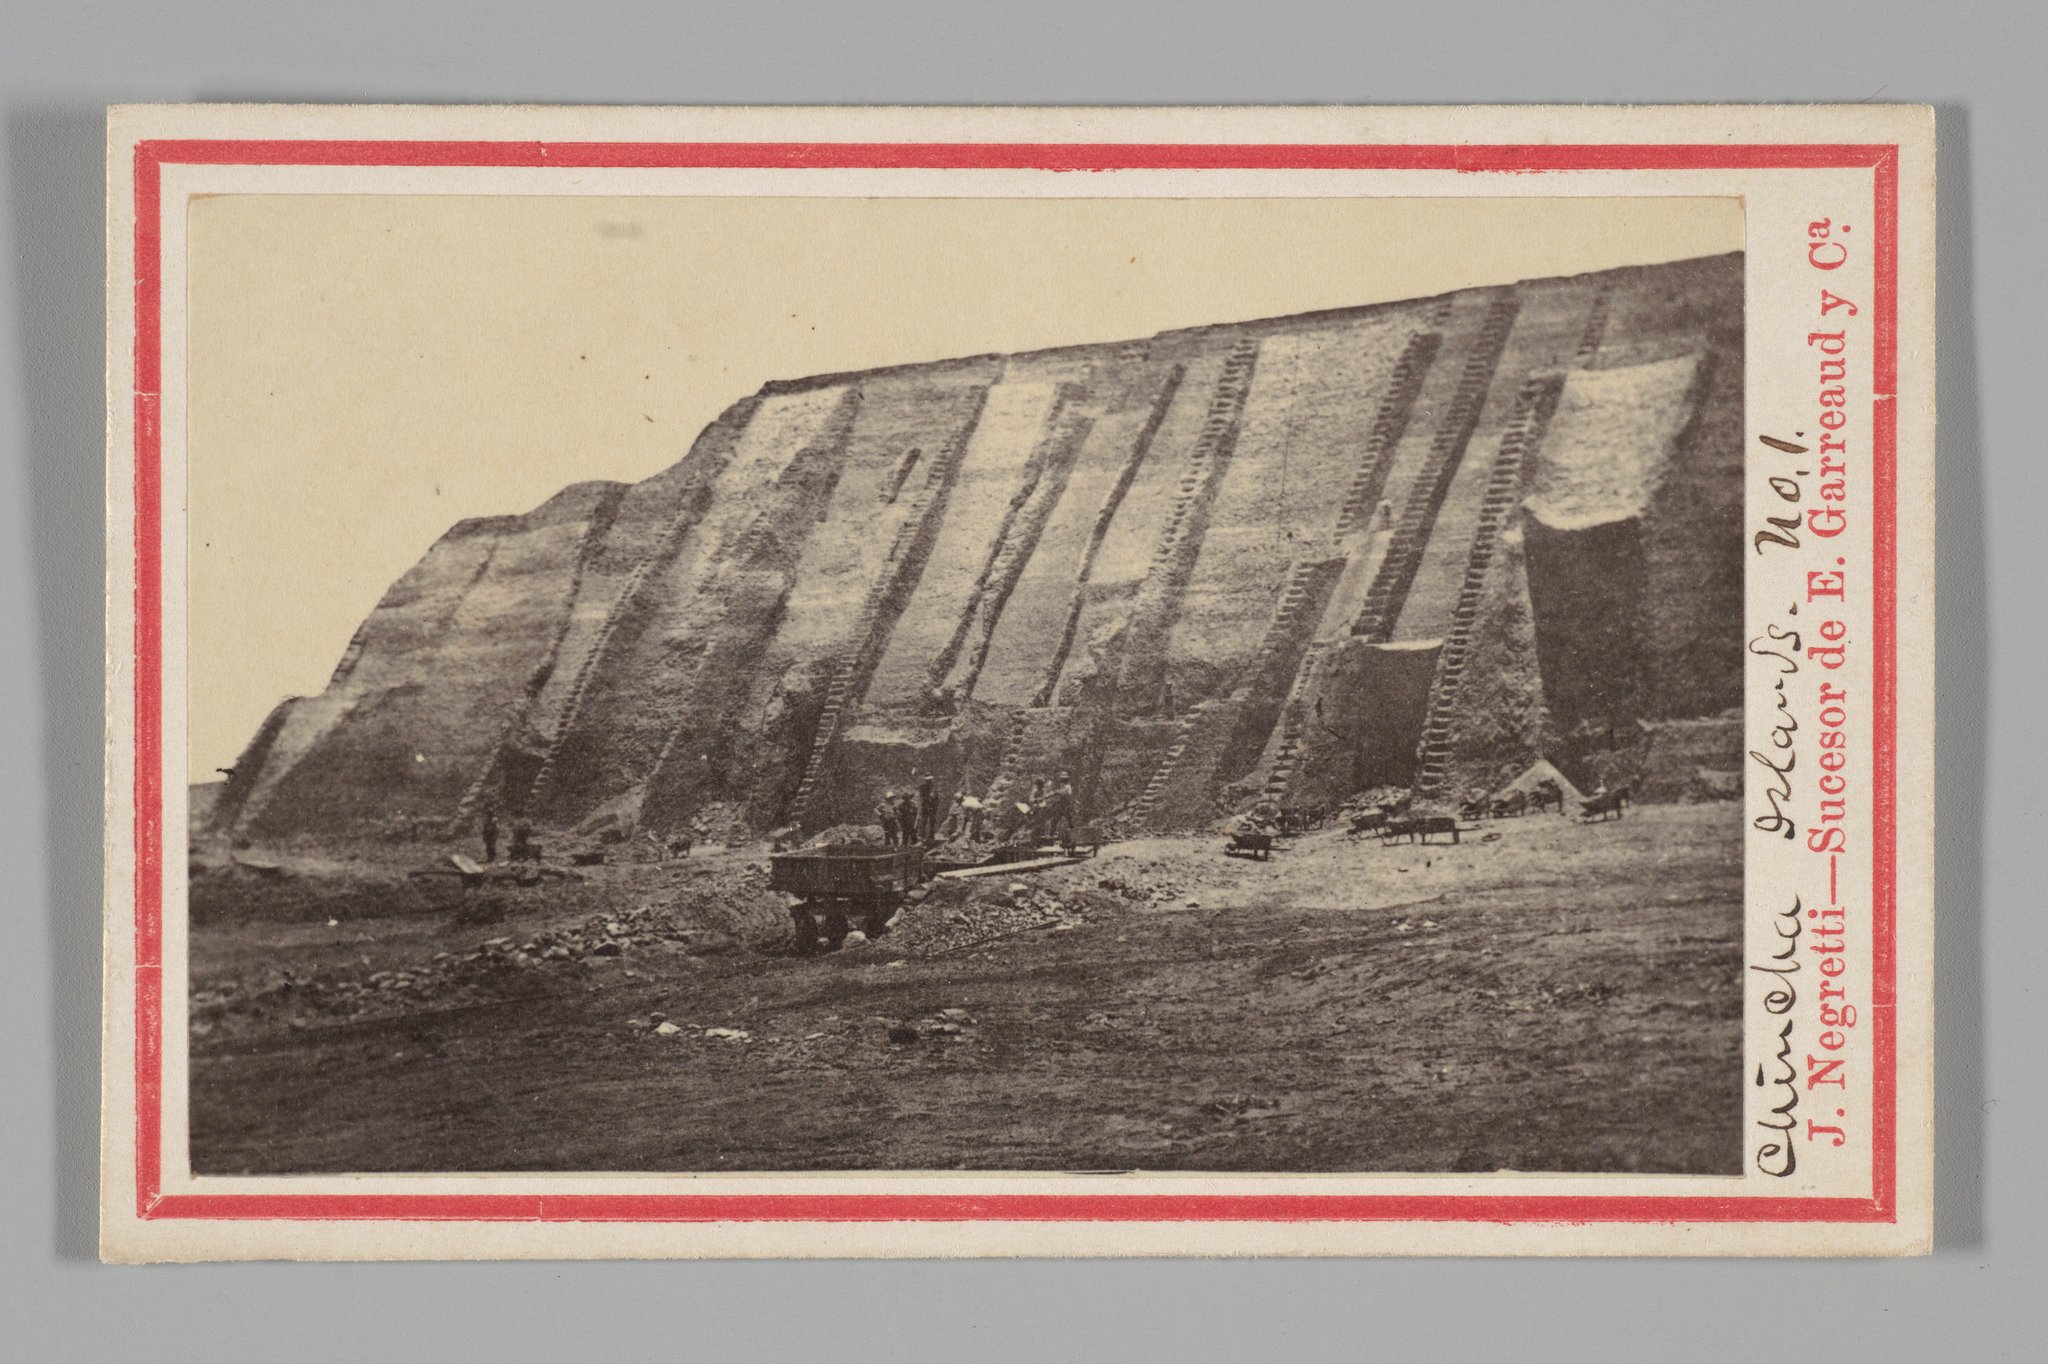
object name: carte de visite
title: [Mining Site Chincha Islands, Lima]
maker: josé negretti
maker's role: artist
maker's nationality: peruvian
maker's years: 1840-1880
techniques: albumen silver print